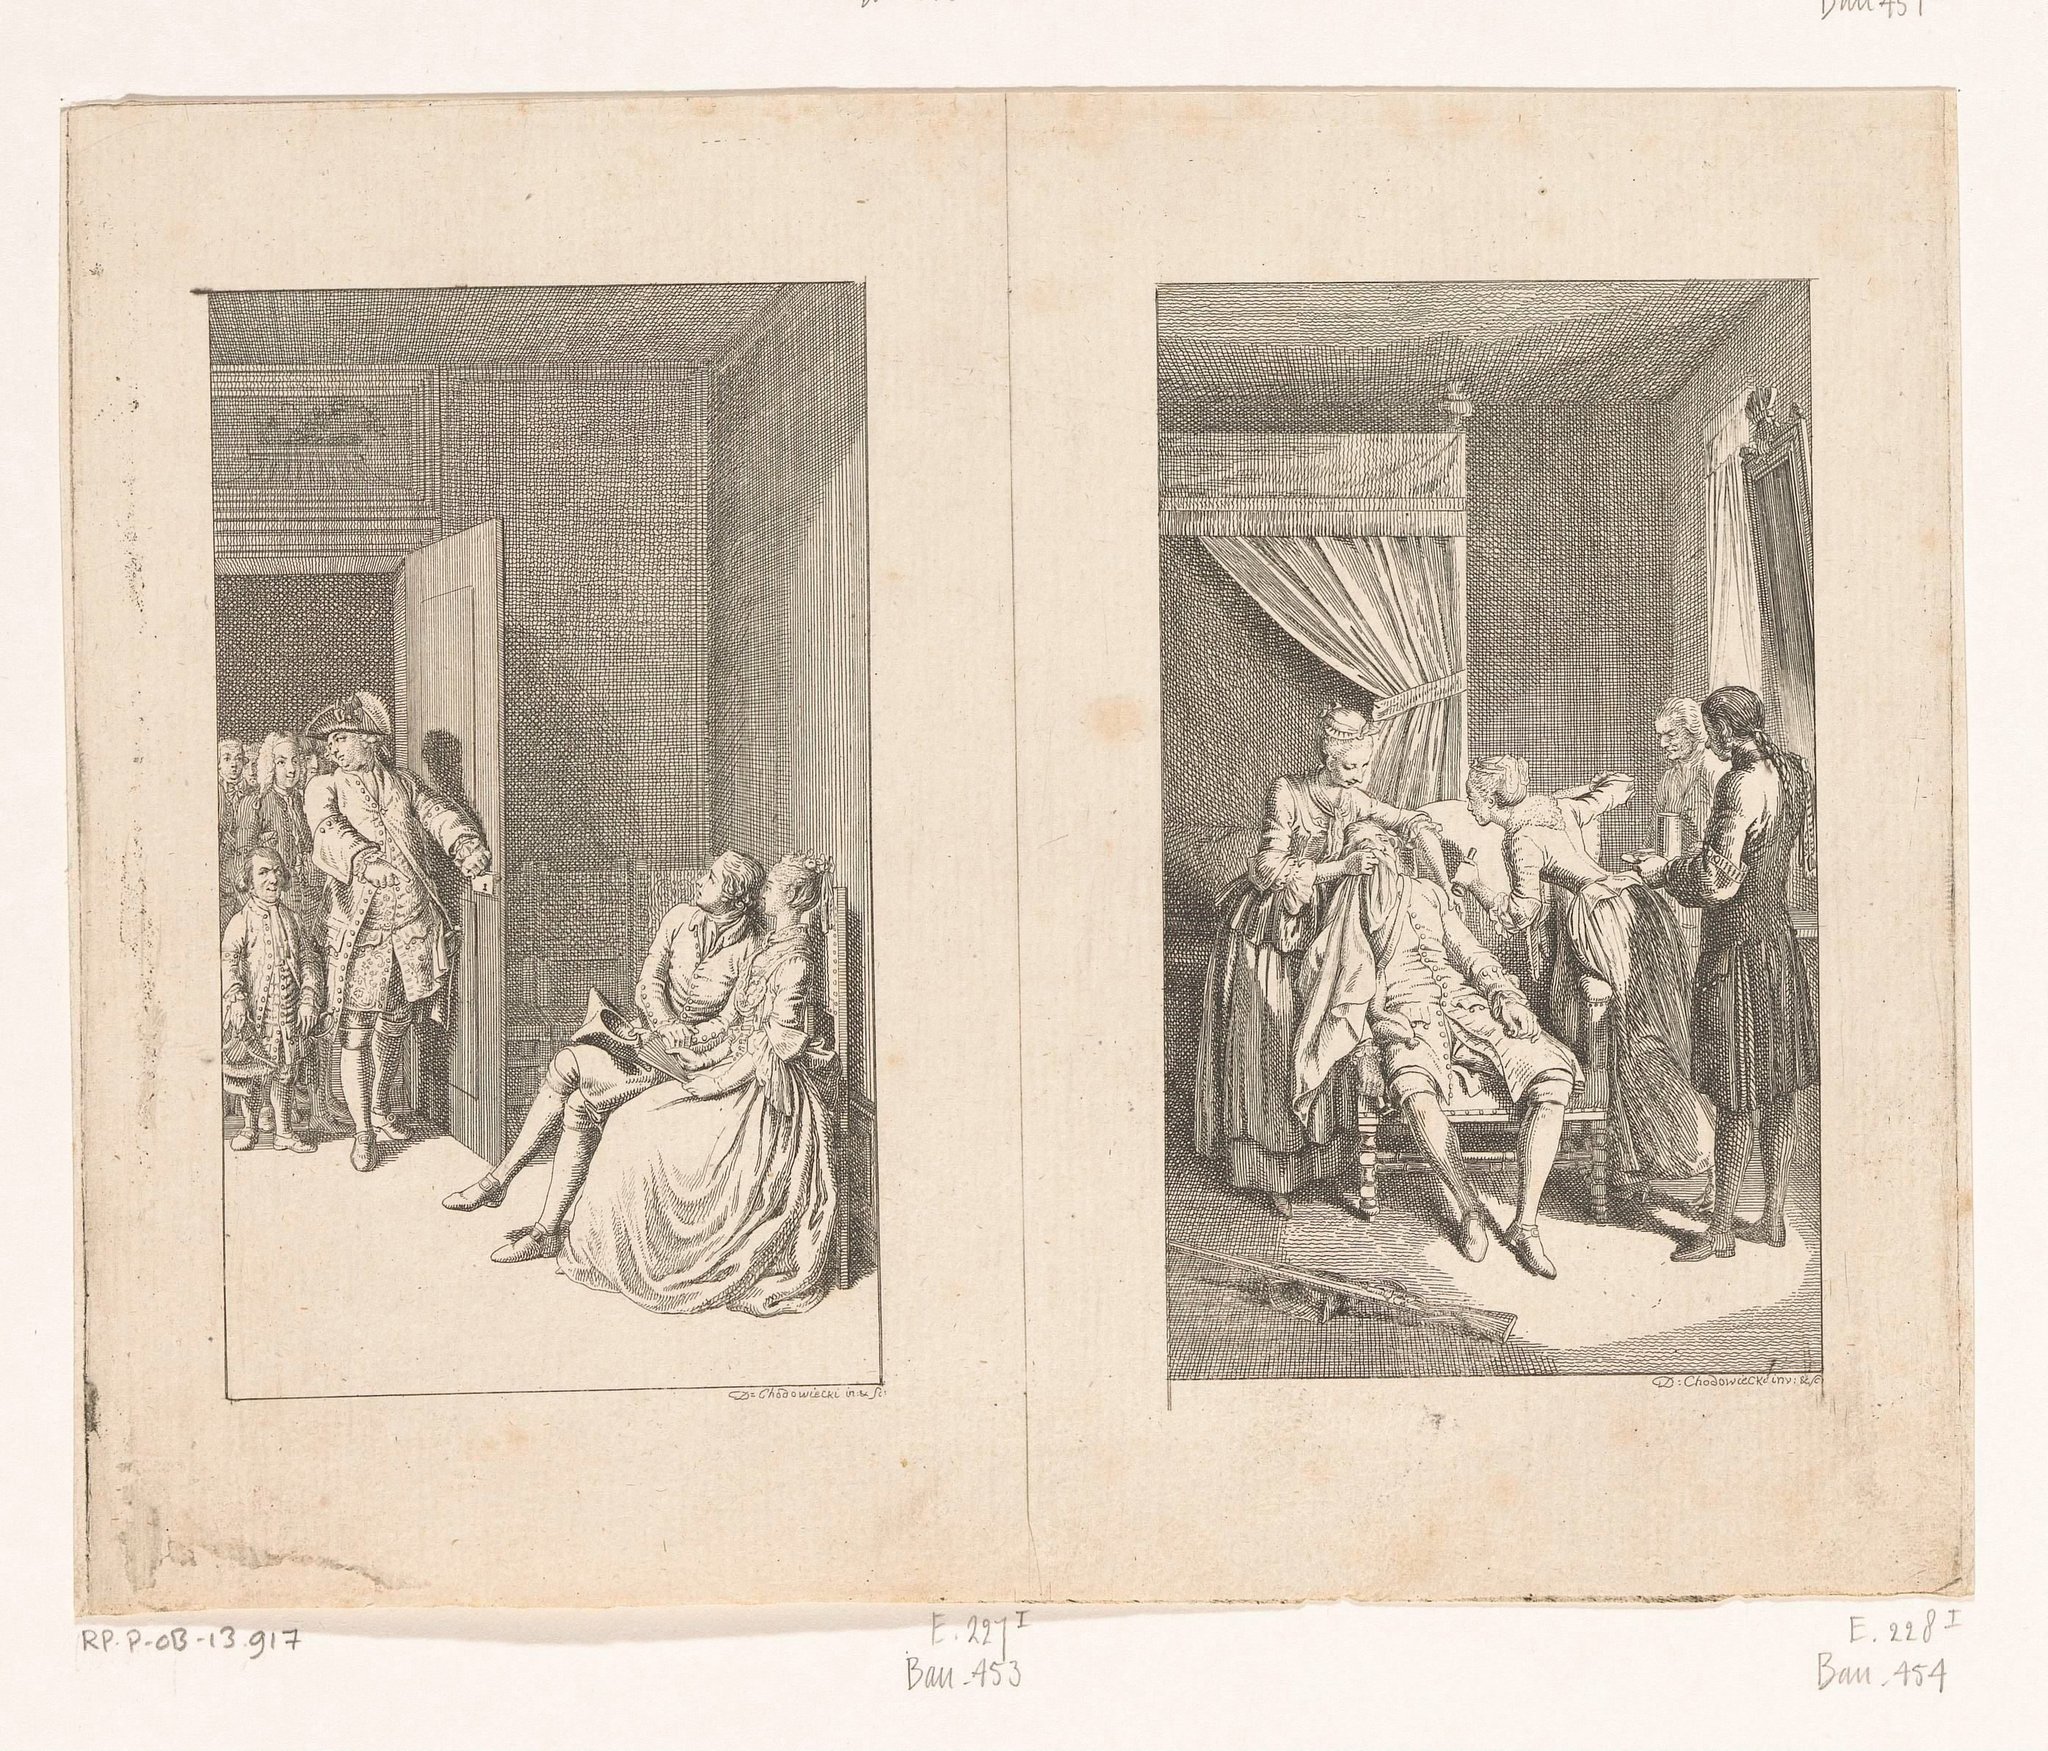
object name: print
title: Twee scènes uit Leben, Bemerkungen und Meinungen Johann Bunkels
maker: daniel nikolaus chodowiecki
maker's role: draughtsman, print maker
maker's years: 1726-1801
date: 1778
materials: paper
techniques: etching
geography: berlin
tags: fainting, swooning, literature, little people, interrupted meeting, lovers caught by surprise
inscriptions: collector's mark: Lugt 2228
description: Links is John Buncle in gesprek met Miss Spence in een kuuroord in Harrogate. Ze worden gestoord door een groep Ierse vrienden van John Buncle. Onder hen bevindt zich Mr. Mackins die slechts vier voet hoog is. Rechts een scène uit het levensverhaal van Alvarez Douror. Op zoek naar Belvidera Dellon, zijn ontvoerde verloofde, komt hij terecht in een huis met een betoverde tuin waar hij op een bank ineenstort. Bedienen brengen hem naar binnen en wanneer hij weer bijkomt kijkt hij in de ogen van zijn geliefde.